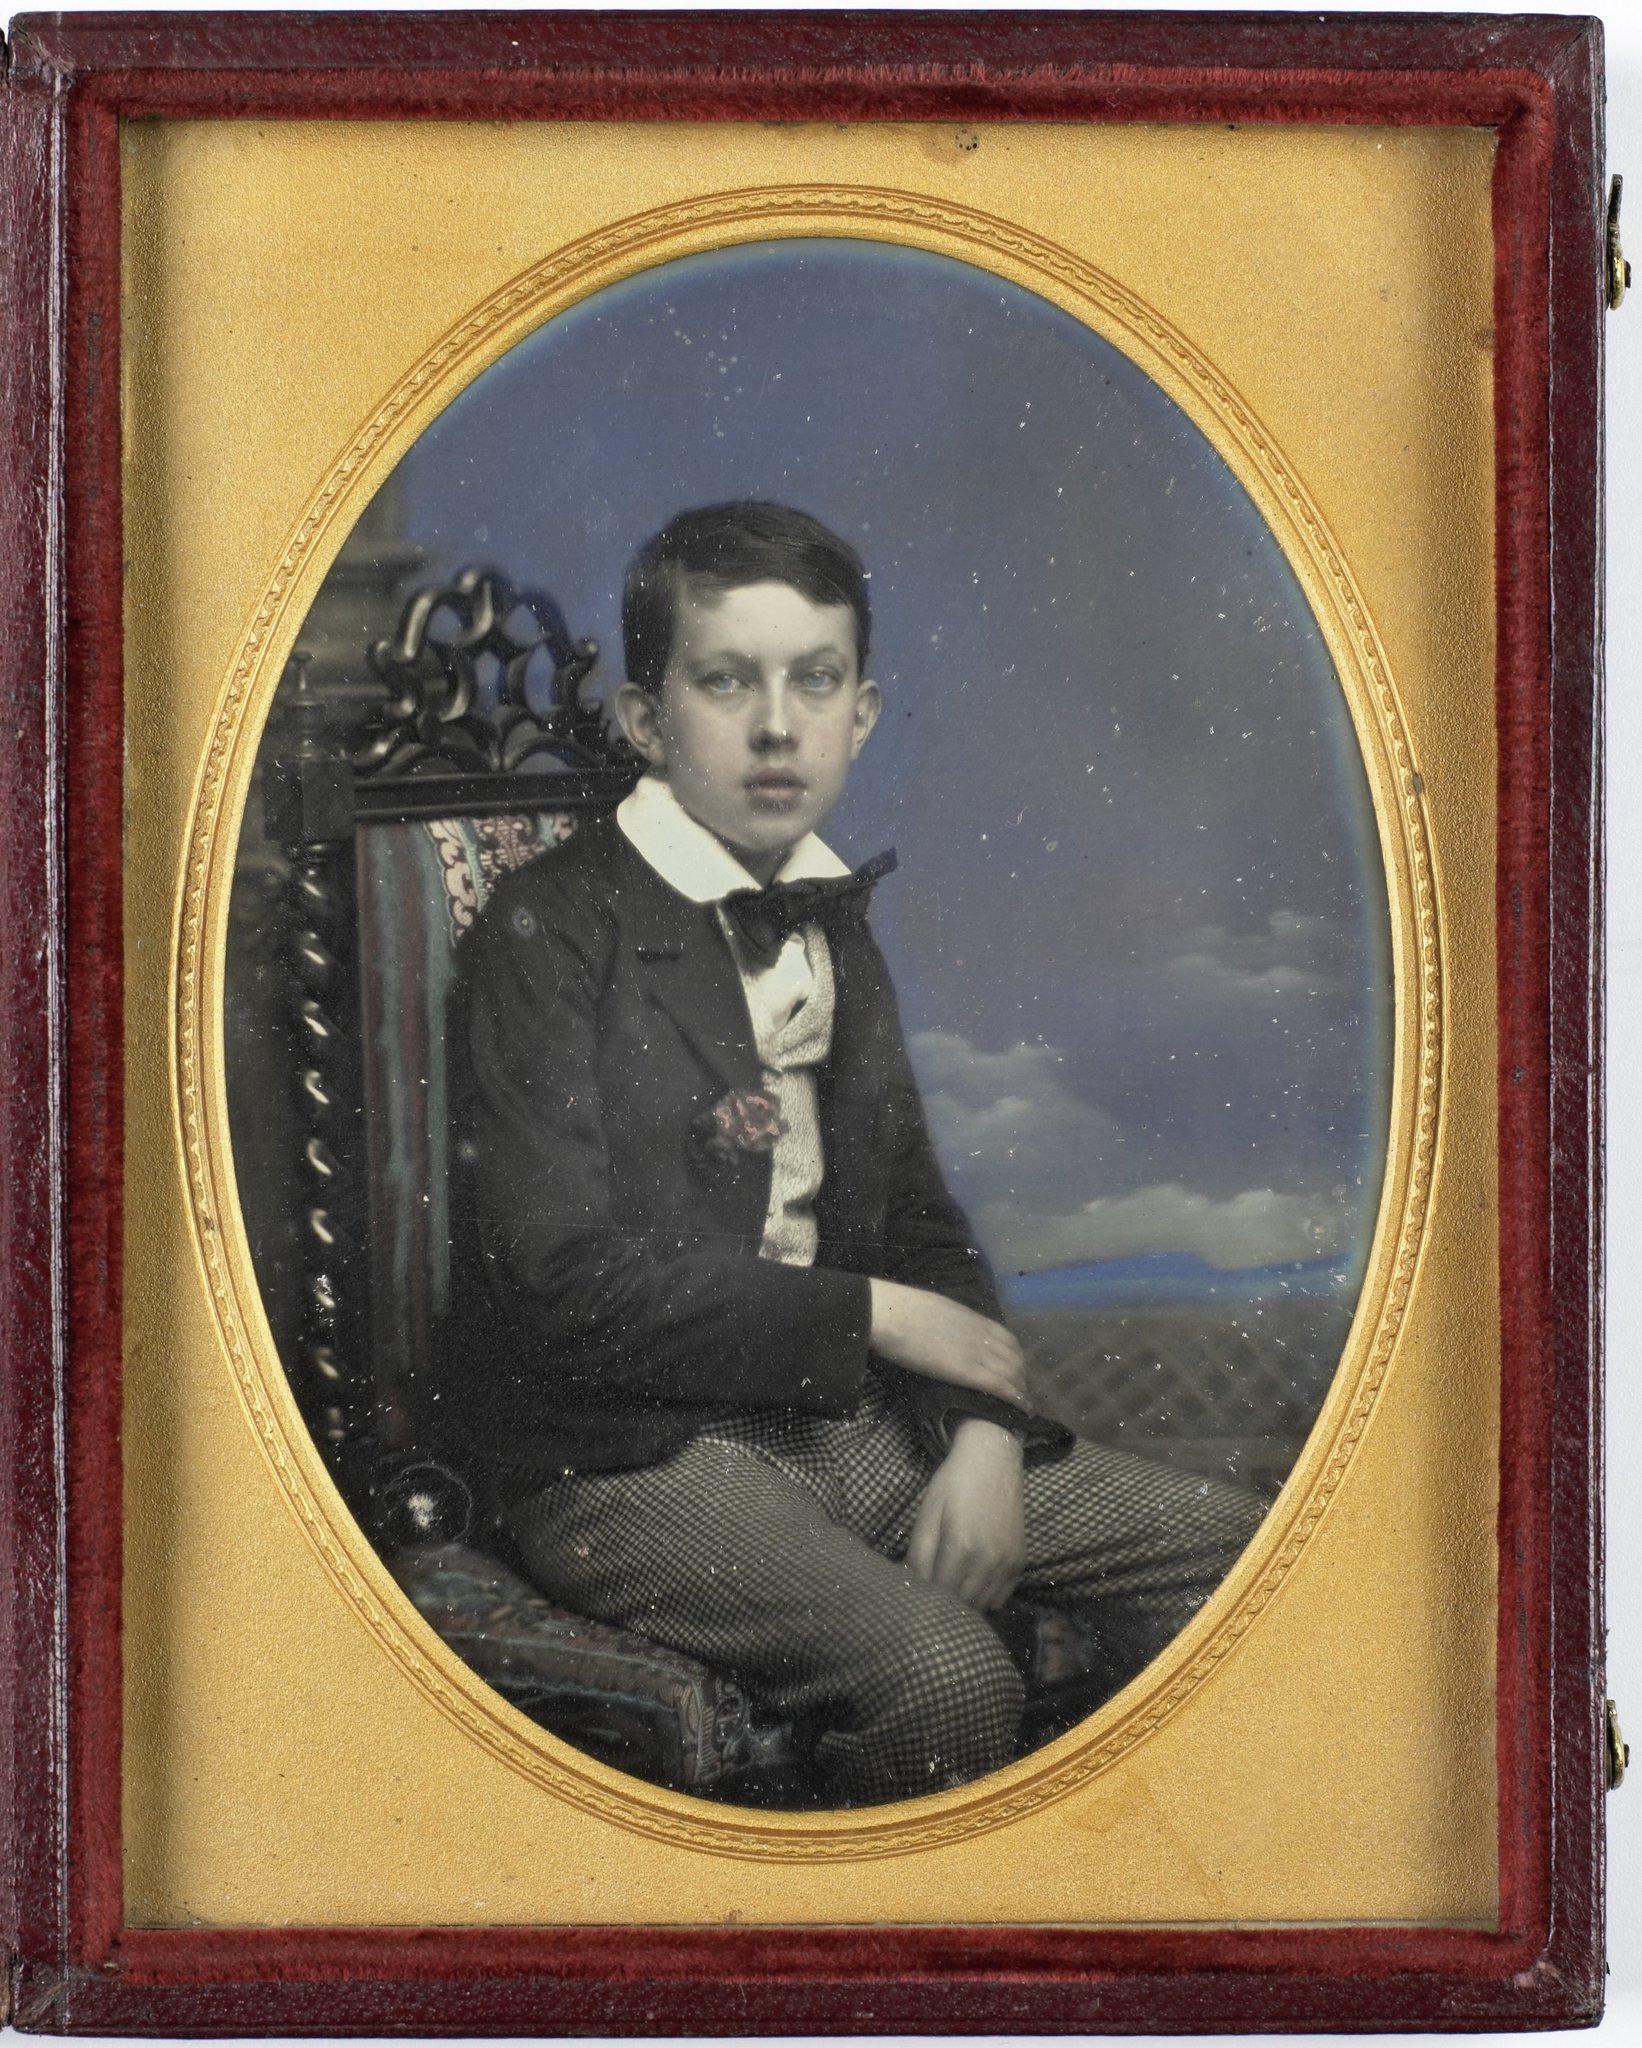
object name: photograph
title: Portret van een onbekende jongen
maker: r. lowe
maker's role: fotograaf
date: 1840-1860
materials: copper, glass, leather, velvet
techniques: daguerreotype, hand coloring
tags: boy (child between toddler and youth), historical persons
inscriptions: inscription: ‘Promenade Cheltenham/ R. Lowe’